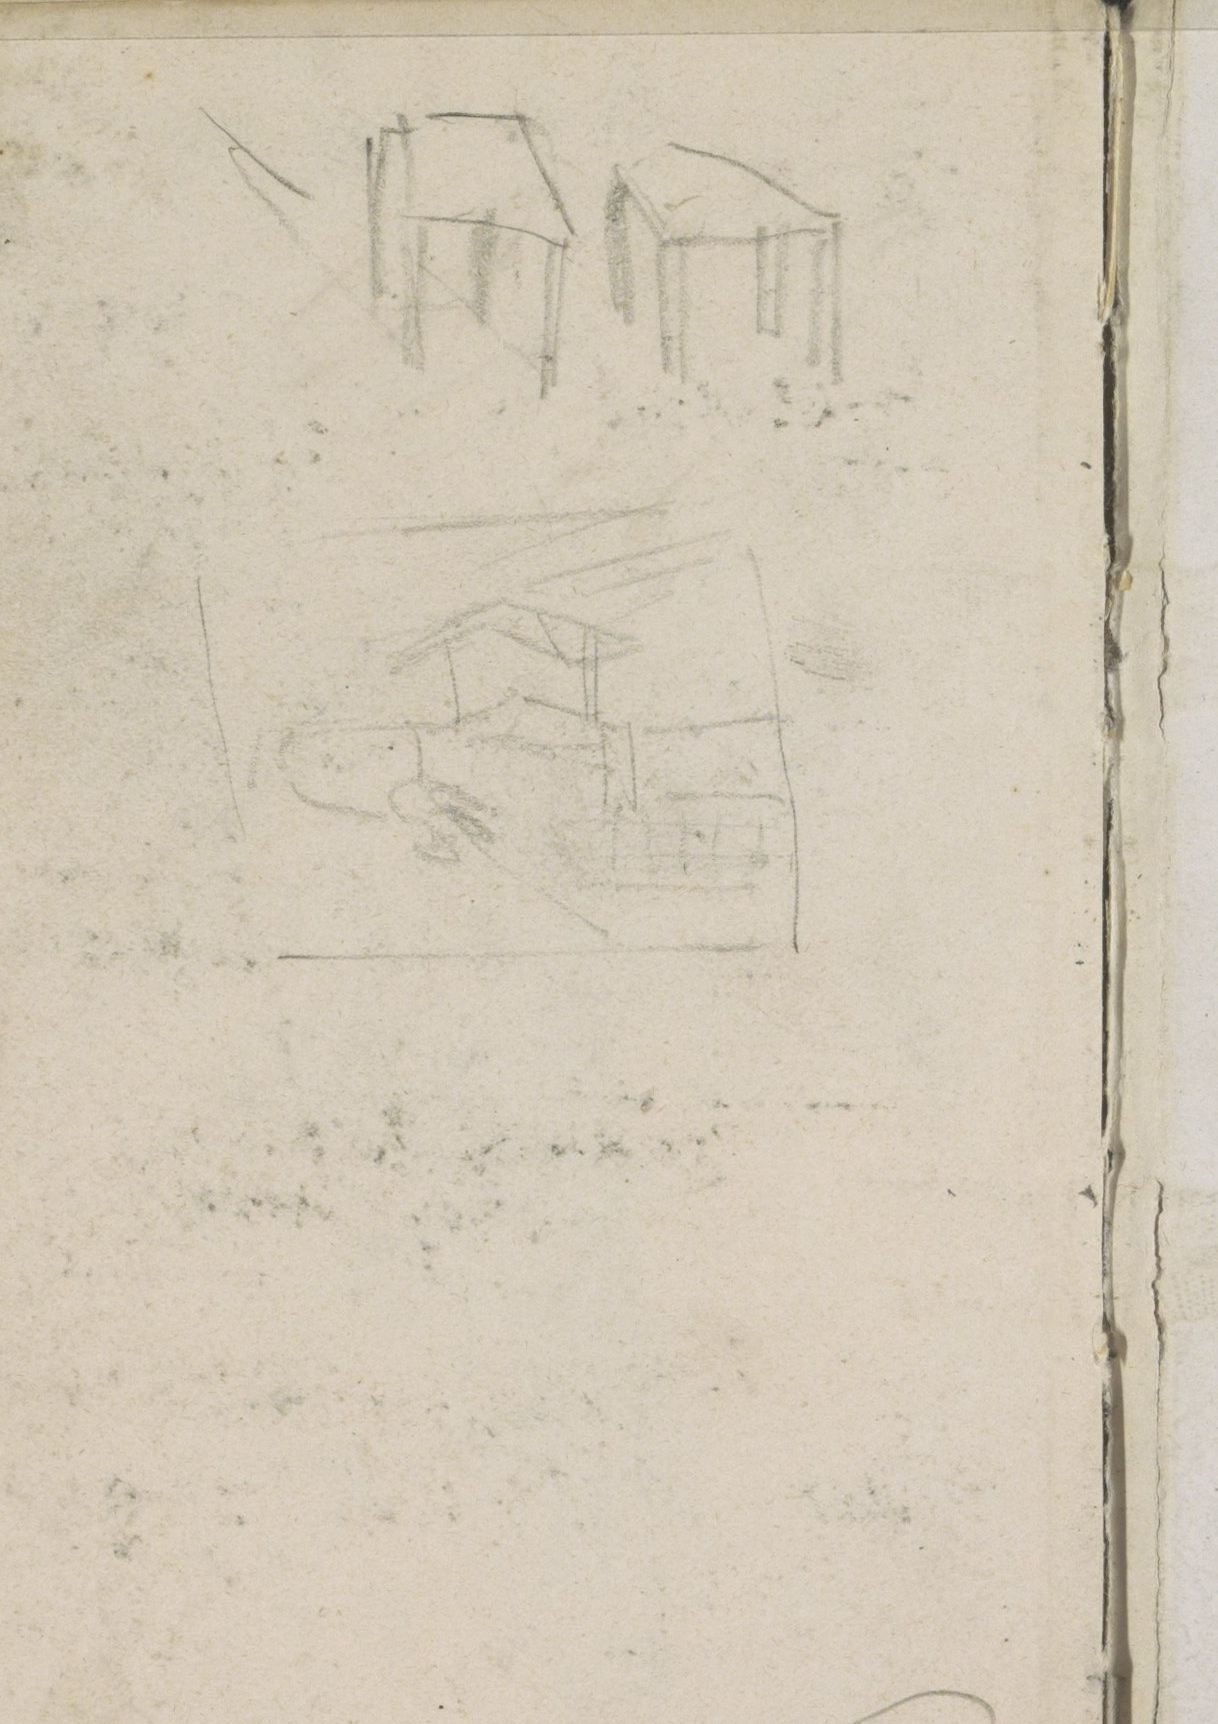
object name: sketchbook leaf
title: Compositiestudie en twee tafels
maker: george hendrik breitner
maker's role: draughtsman, painter, print maker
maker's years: 1857-1923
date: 1912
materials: paper, pencil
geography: amsterdam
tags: table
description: Pagina 33 uit een schetsboek met 16 bladen.